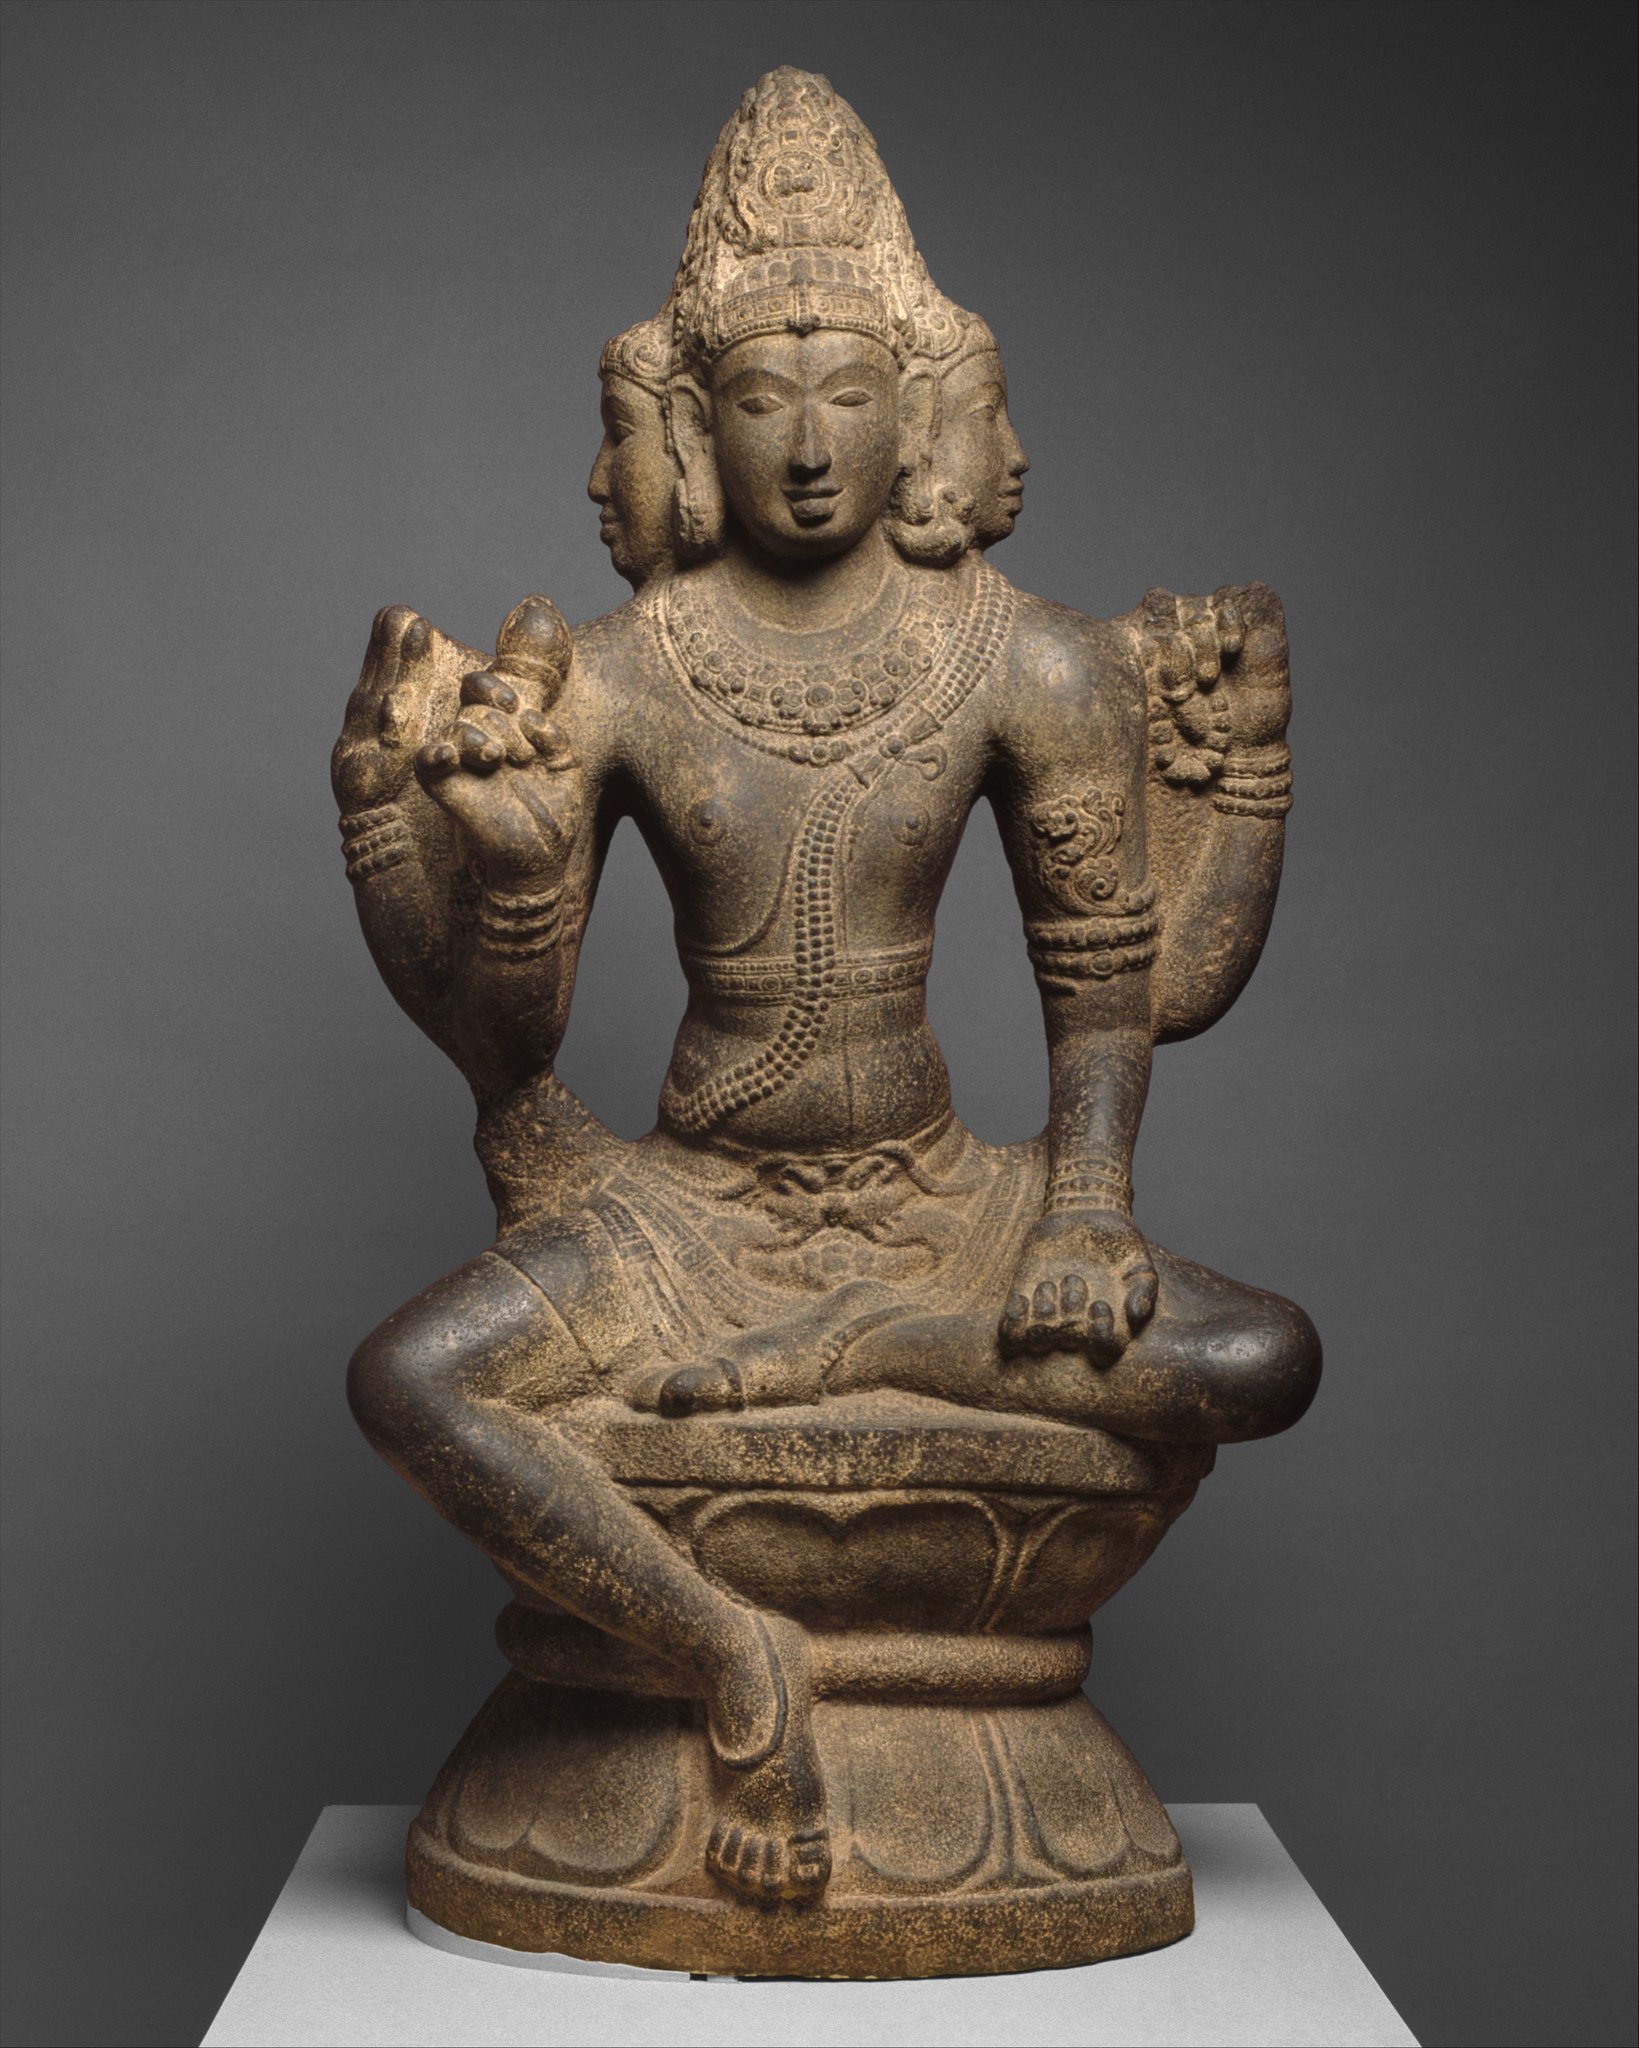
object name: figure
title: Shiva as Mahesha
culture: tamil nadu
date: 901-1000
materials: granite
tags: shiva,hinduism